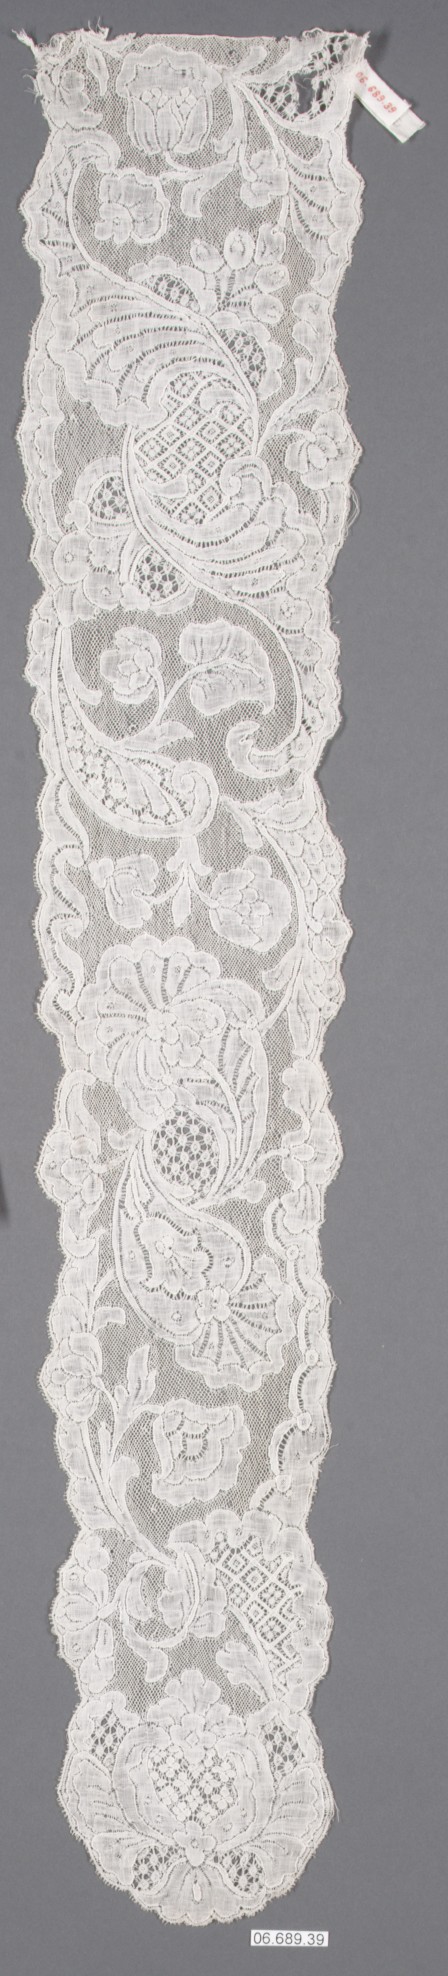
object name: lappet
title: Lappet (one of a pair)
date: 1701-1733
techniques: lace